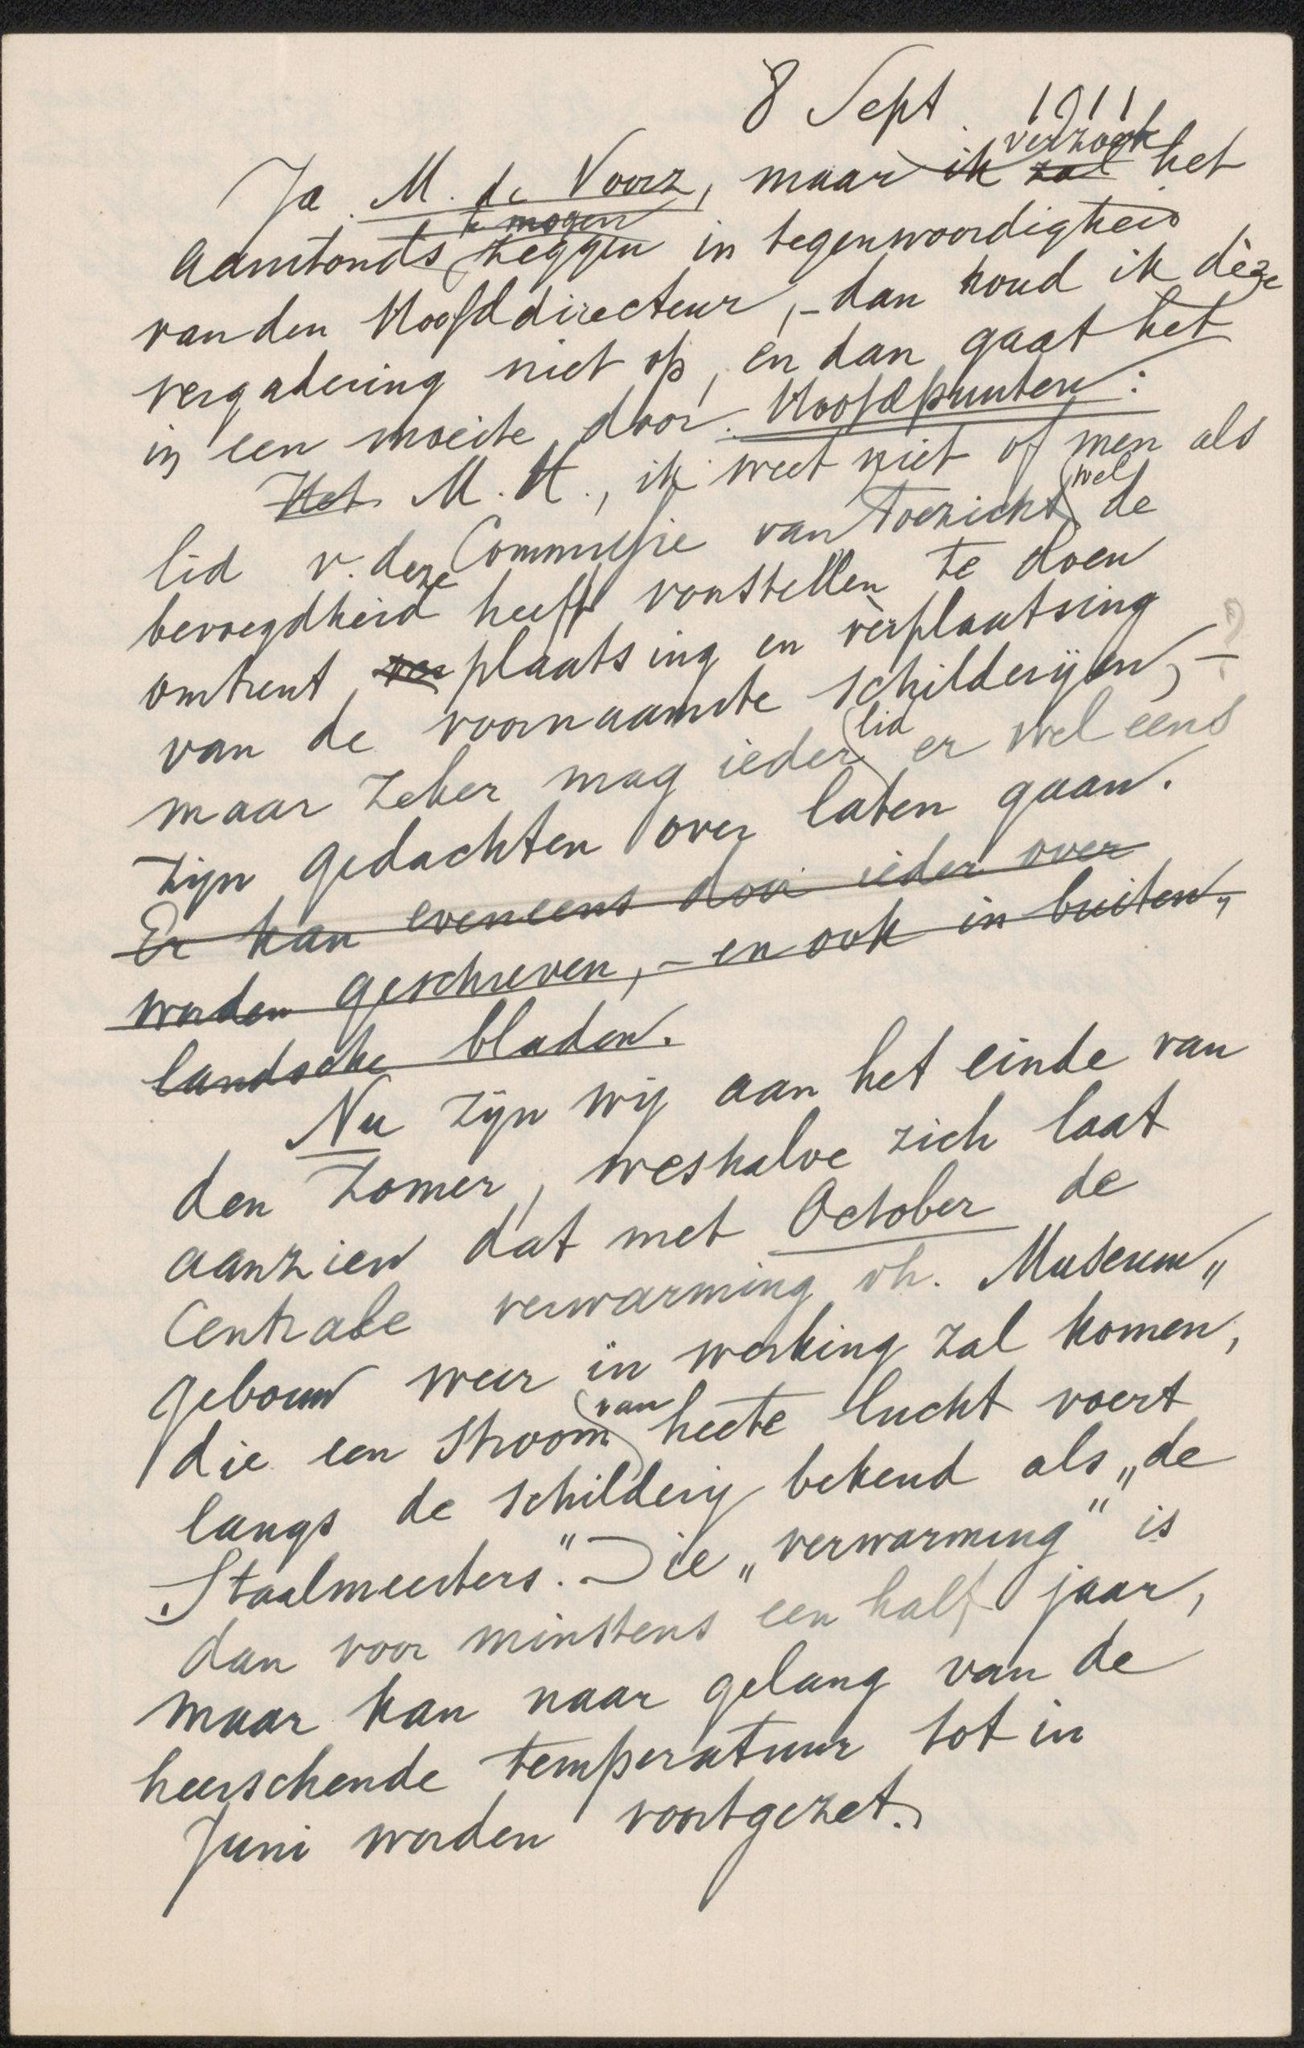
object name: aantekening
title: Aantekening uit collectie August Allebé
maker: august allebé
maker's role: draughtsman, print maker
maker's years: 1838-1927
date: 1911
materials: ink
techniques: pen, writing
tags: antwerp, joachim bueckelaer, leiden, rembrandt van rijn, rijksmuseum amsterdam, painting (including book-illumination, miniature-painting)